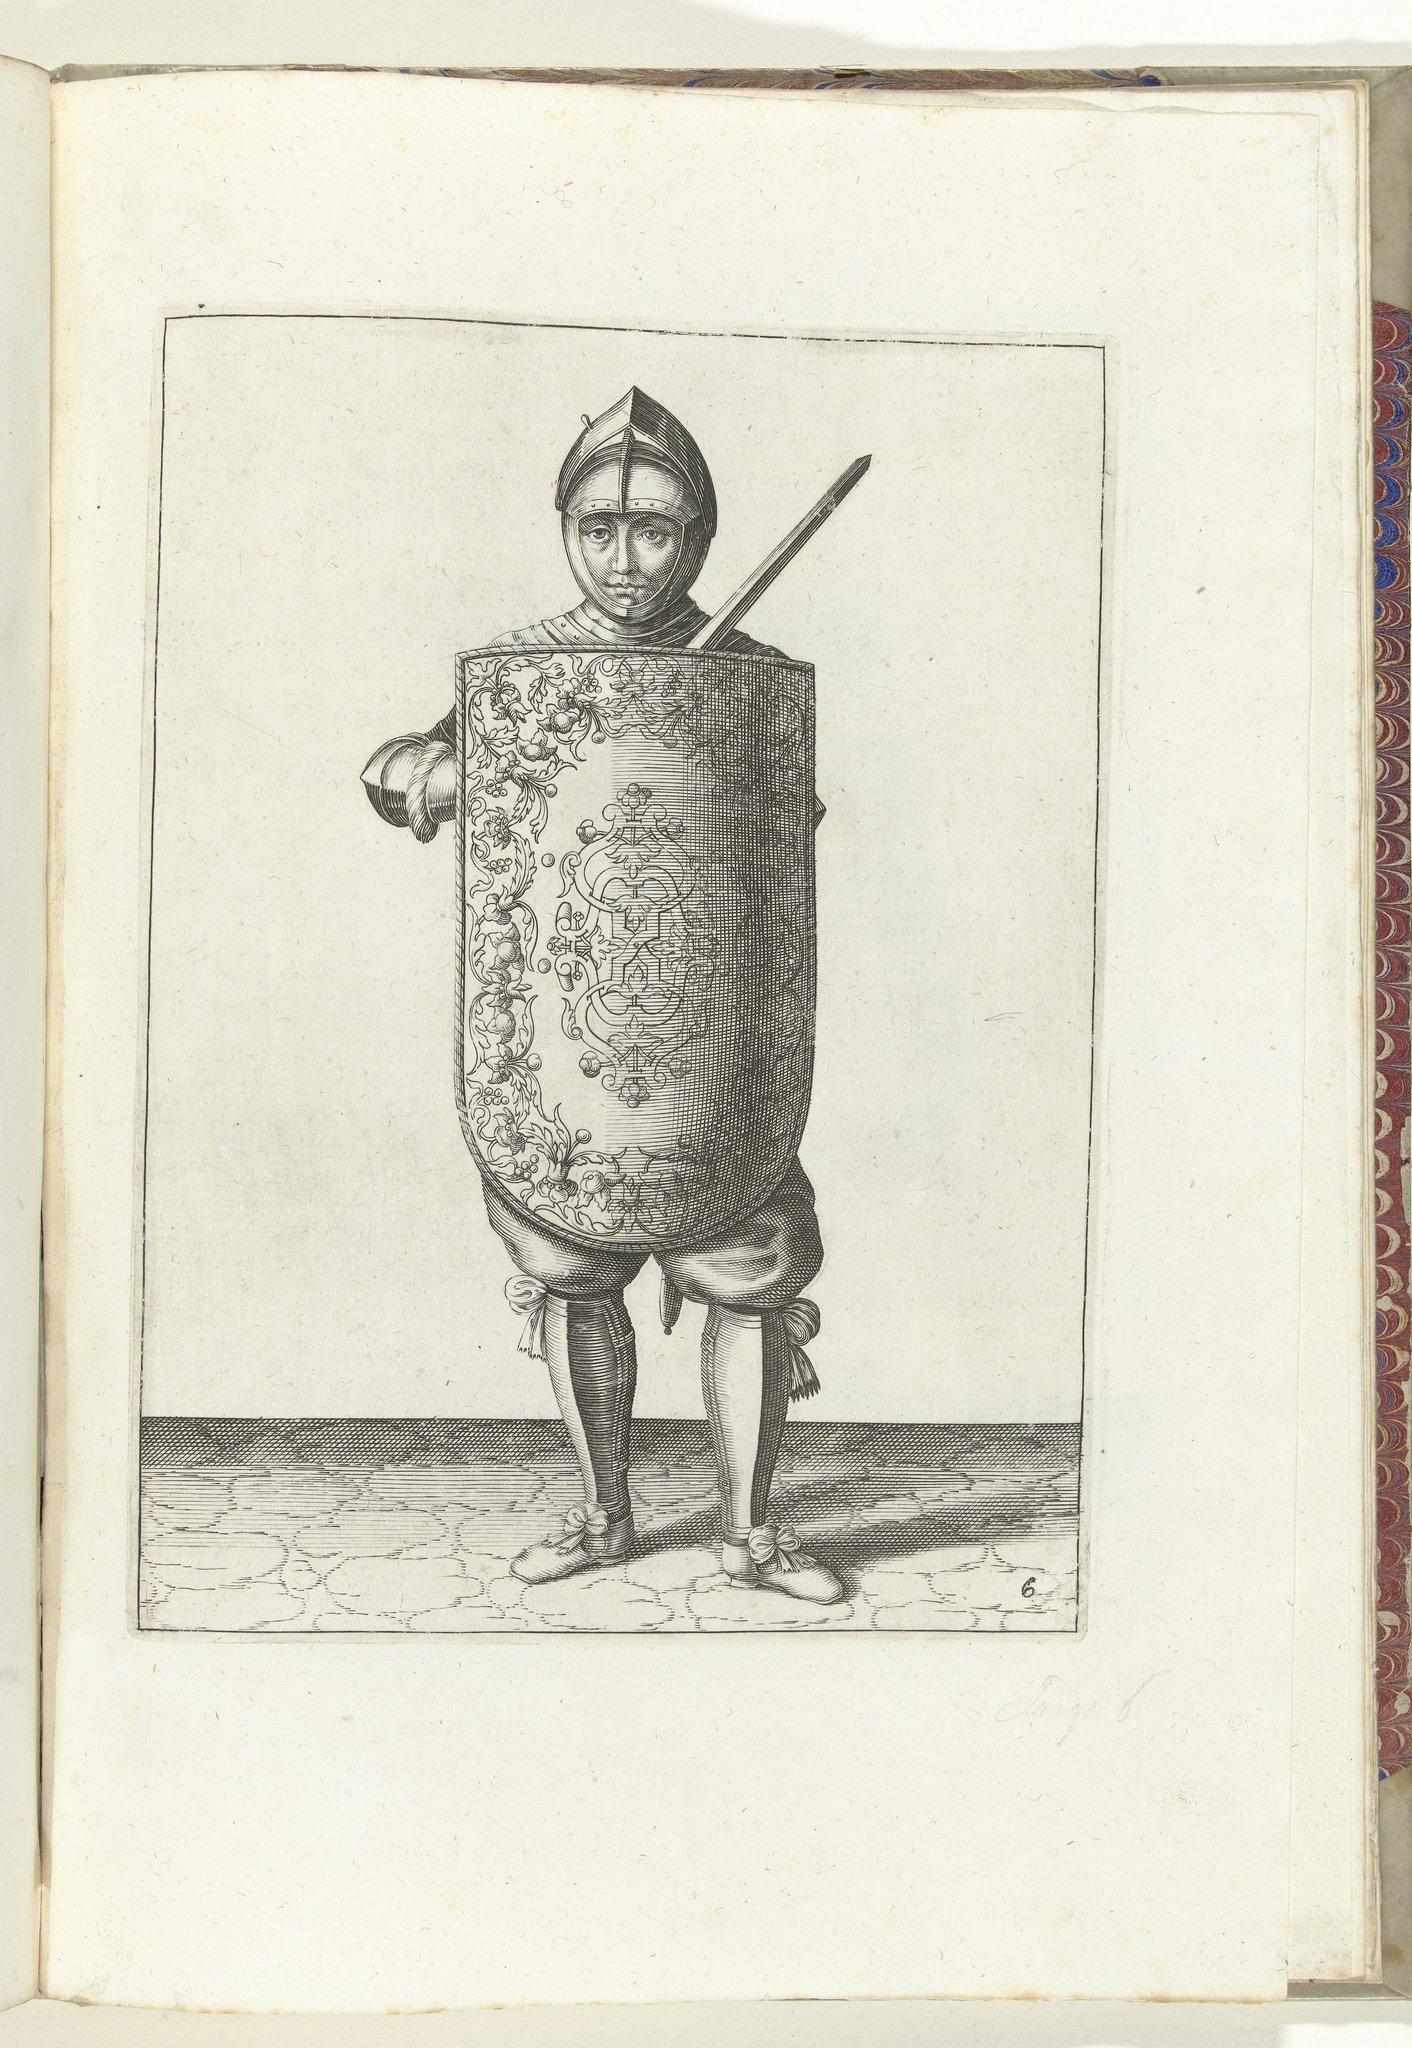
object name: print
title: De exercitie met de targe en rapier: de soldaat houdt de targe voor de borst en de getrokken rapier tegen de linkerschouder (nr. 6), 1618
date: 1616-1618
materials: paper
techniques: engraving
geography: northern netherlands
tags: the hague, maurice (prince of orange), handling of weapons ~ military training, weapons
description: Illustratie in: Adam van Breen, De Nassausche Wapen-Handelinge, van Schilt, Spies, Rappier ende Targe : beyde figuerlick afgebeelt, ende gestelt na de nieu ordening [van] ... Maurits van Nassau / Korte Onderwijsinge op de figuerlijcke af-beeldinghe belangende 'trecht ghebruyck van al 'tghene een Soldaet noodigh is in het handelen vande Targes met het Rappier, 's-Gravenhage, [Aert Meuris] 1618, plaat nr. 6. In het exemplaar in de collectie van de Rijksmuseum Research Library (326 F 22).